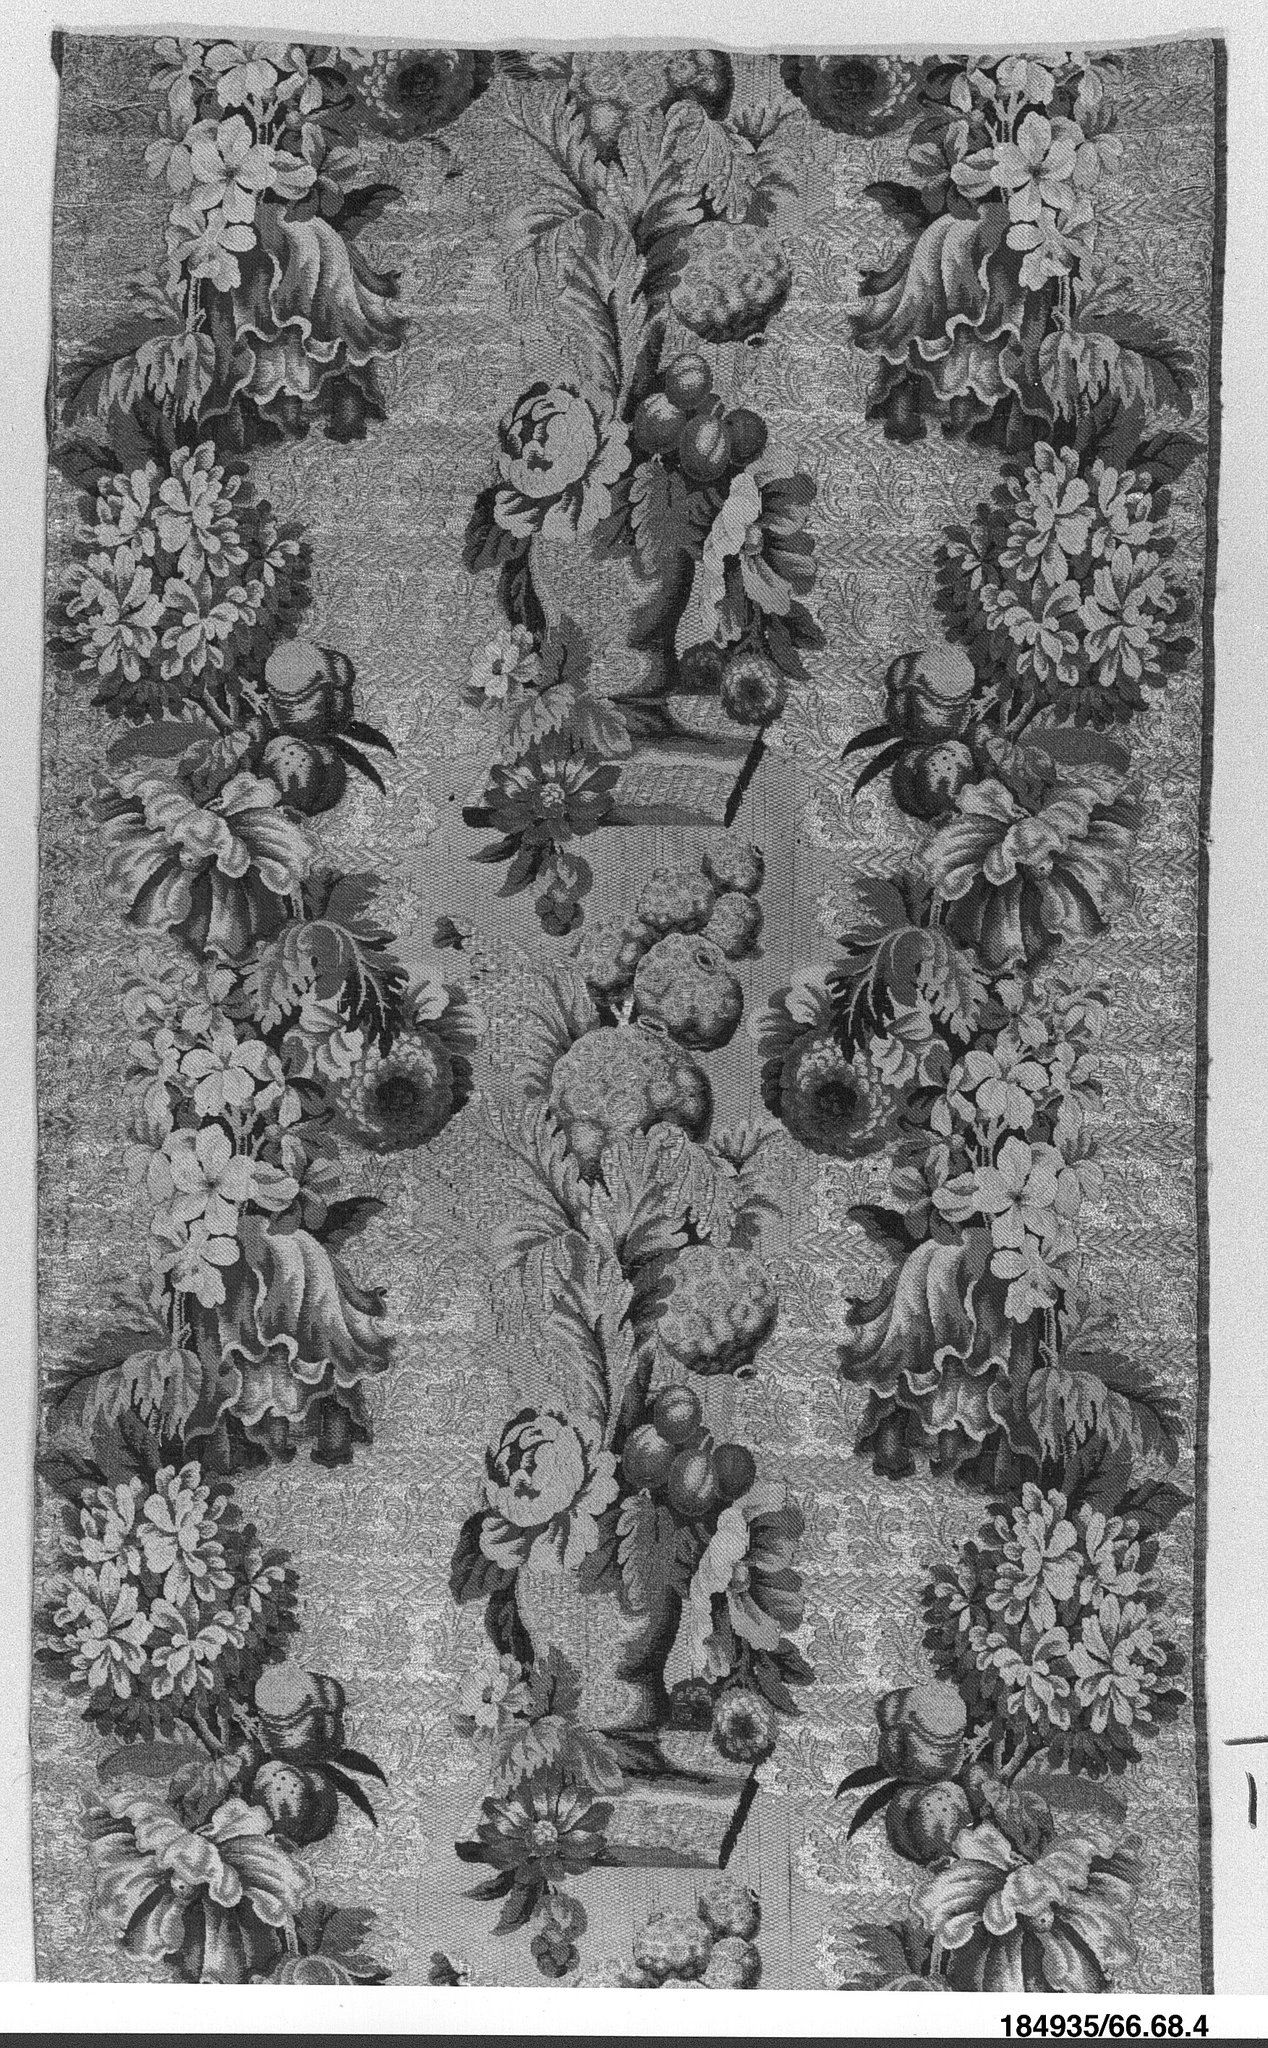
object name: piece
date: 1735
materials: metal thread, silk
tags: flowers,leaves